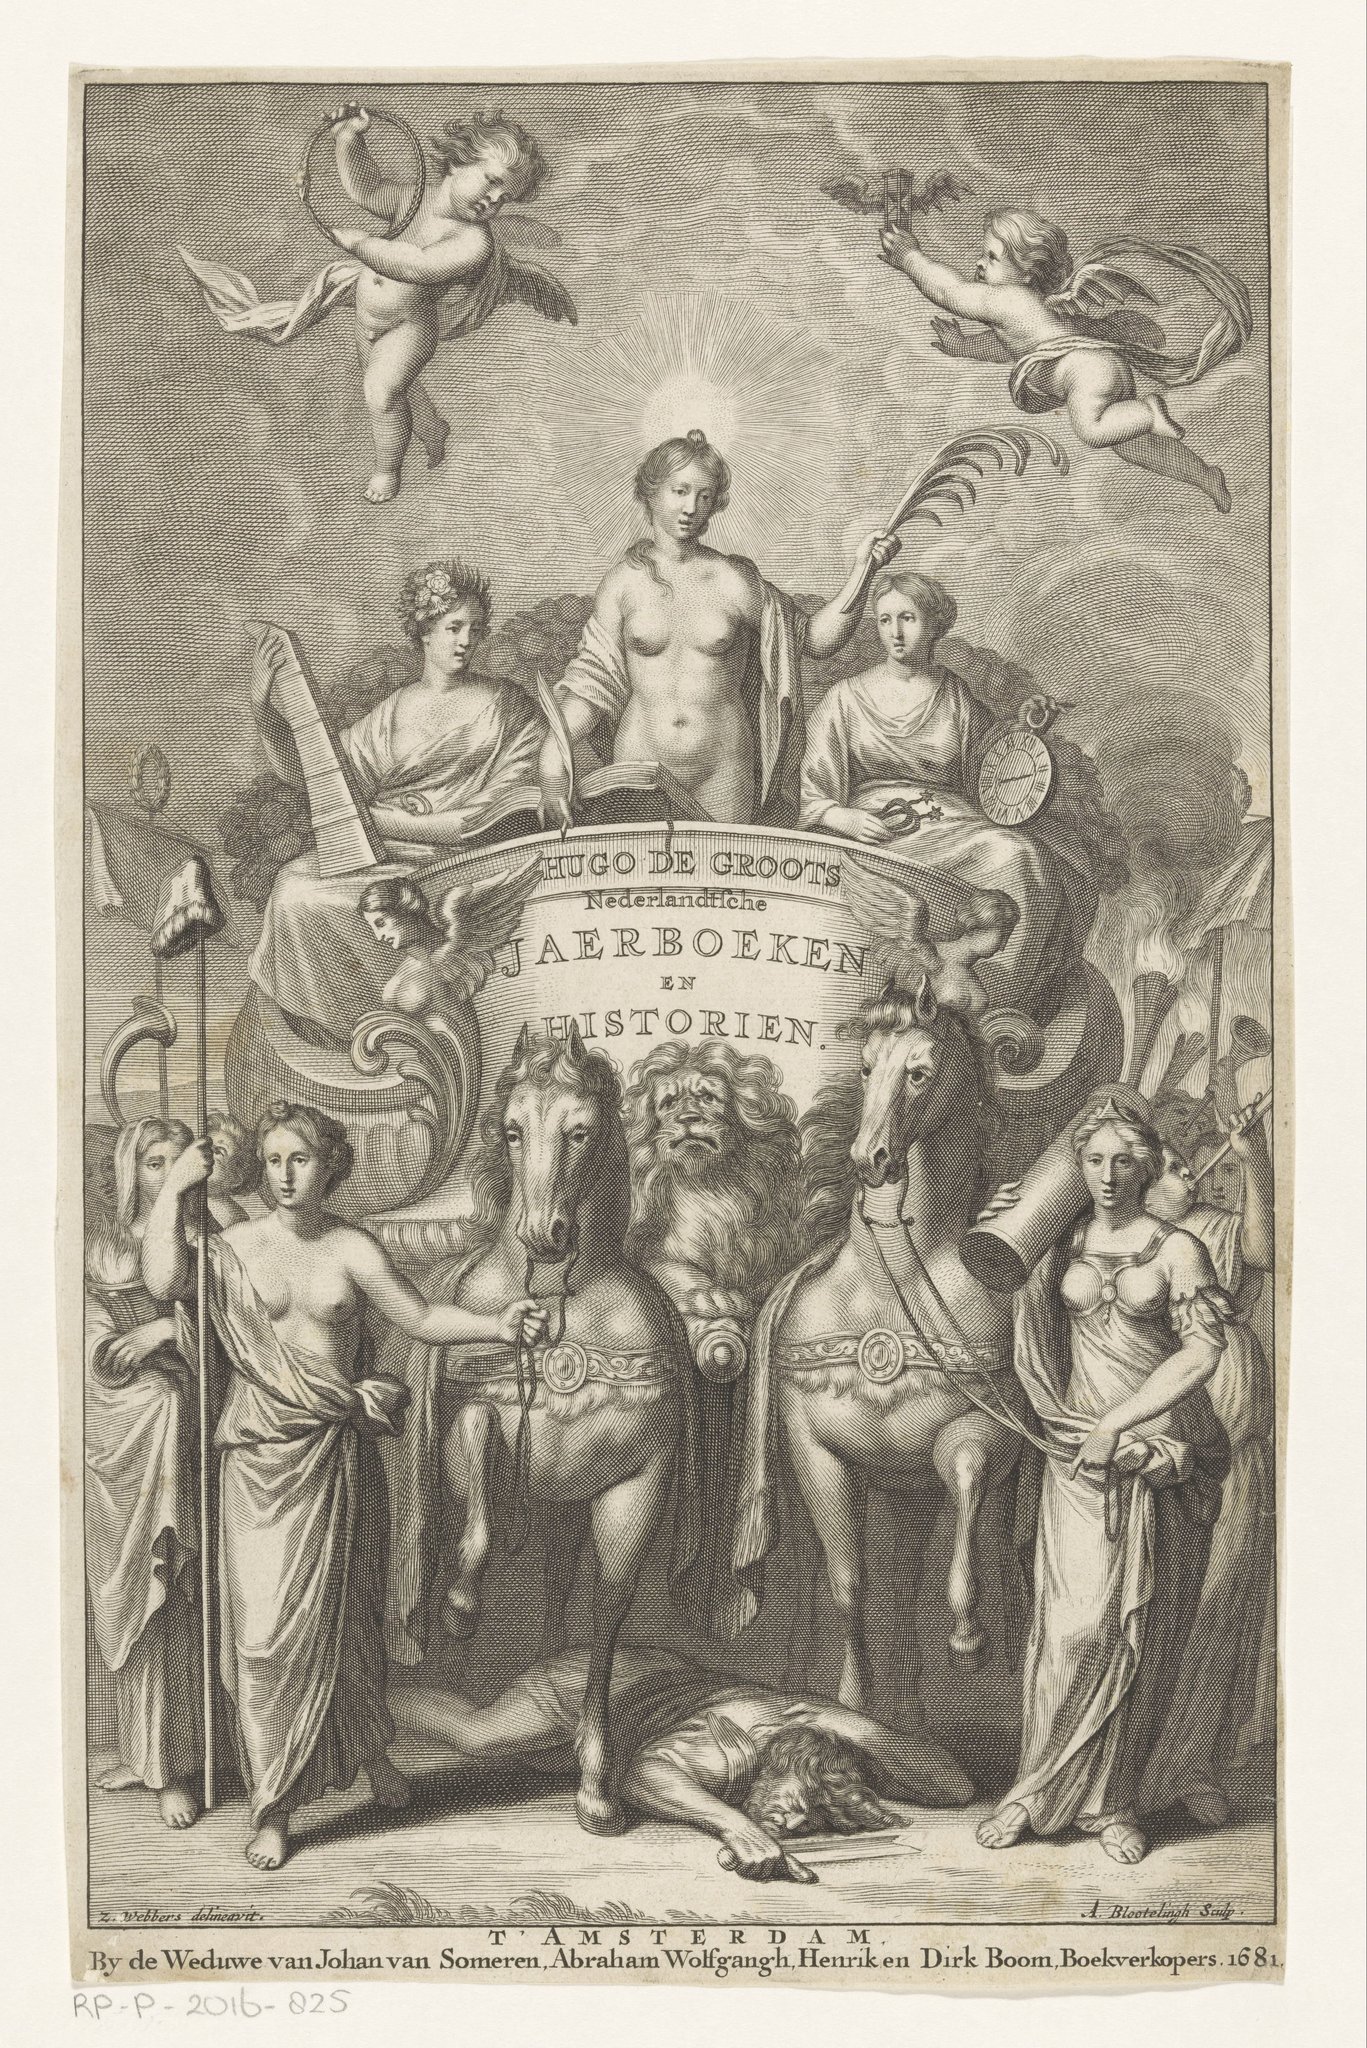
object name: print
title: Titelpagina voor: Hugo de Groot, Nederlandtsche jaerboeken en historien, 1681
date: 1681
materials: paper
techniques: engraving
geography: amsterdam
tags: truth; 'verità' (ripa), 'historia'; 'historia' (ripa)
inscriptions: collector's mark: Lugt 2228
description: Naakte Waarheid staat met palm, pen en het boek van de Geschiedenis in haar hand op een zegewagen getrokken door paarden. Daarbij staan vrouwen met vrijheidshoed, bazuinen, fakkels en een halve zuil. Aan de bovenzijde vliegen twee putti met de slang Ourobouros en een zandloper.